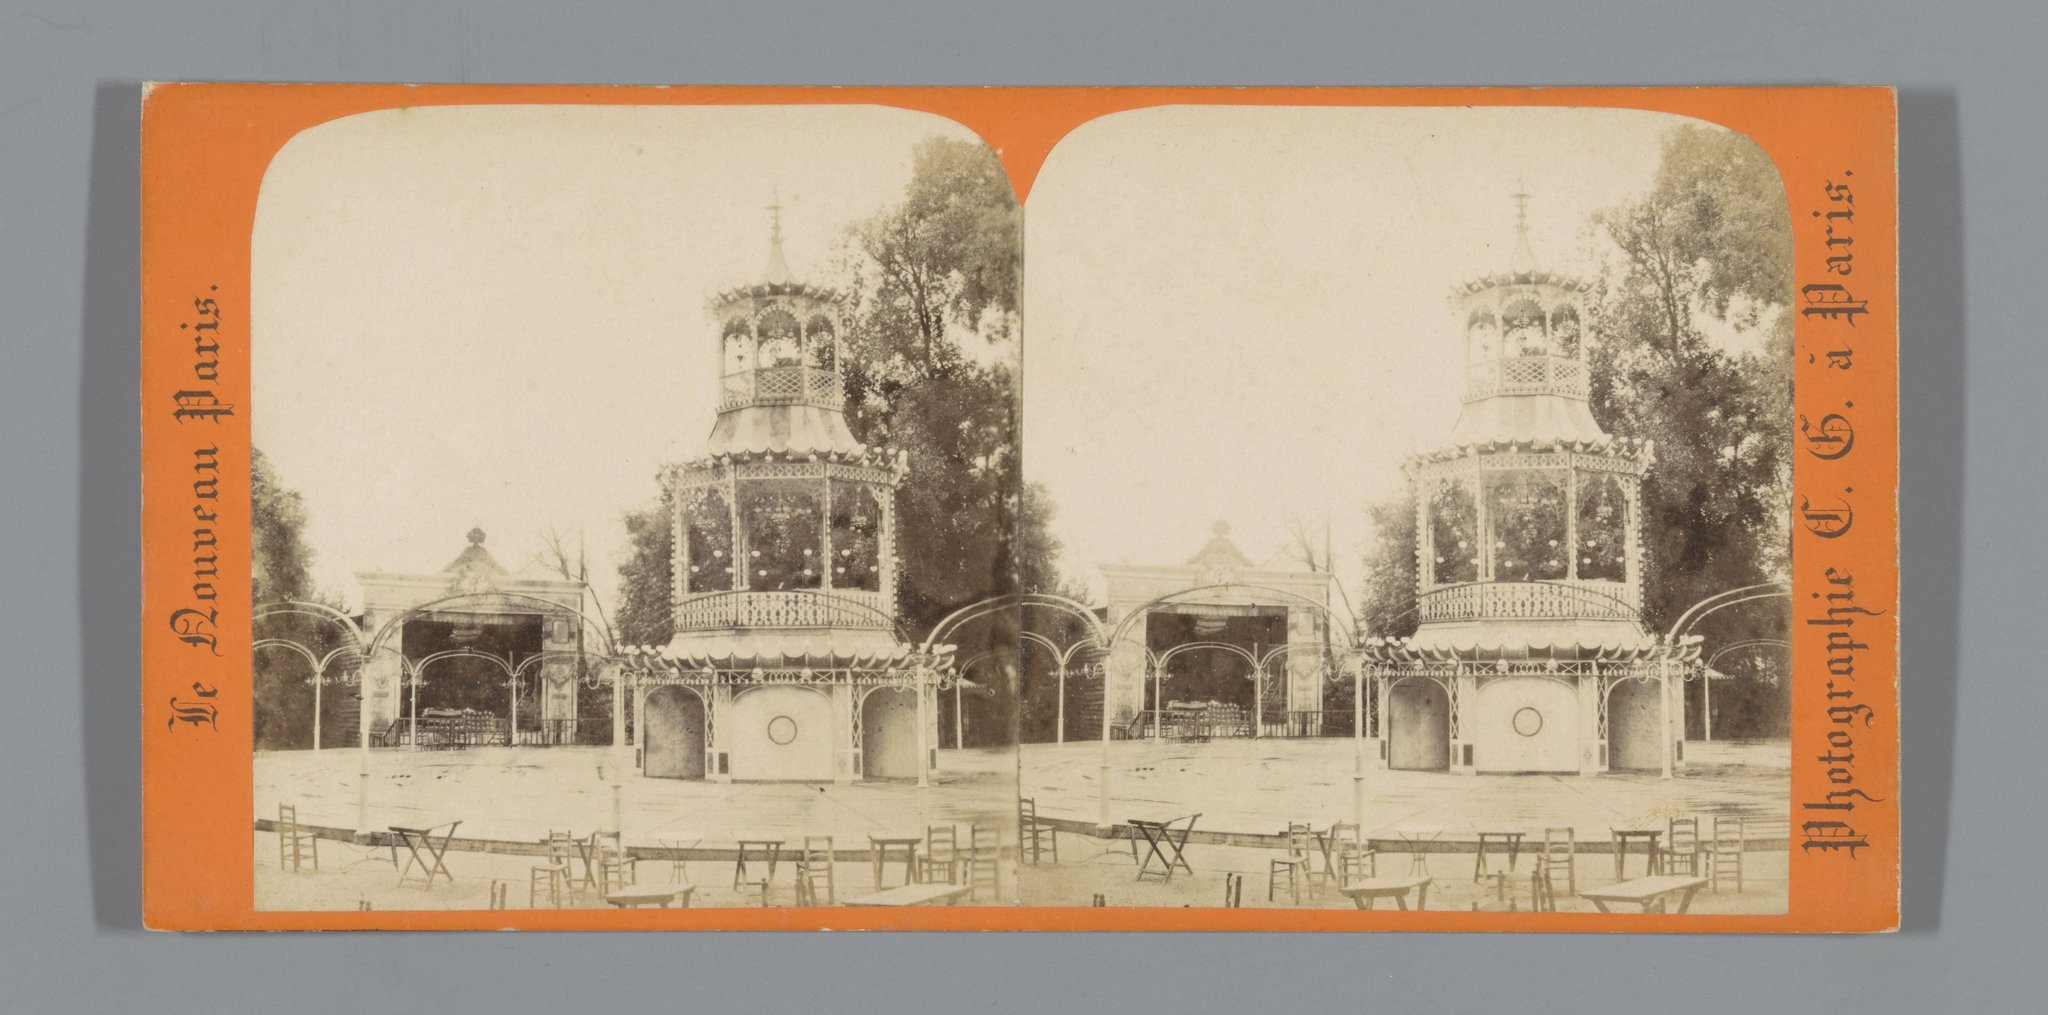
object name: stereograph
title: Prieel en een podium (vermoedelijk) in de tuin van het Château d'Asnières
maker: charles gérard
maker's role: fotograaf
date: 1850-1875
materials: cardboard, photographic support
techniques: albumen print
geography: ile-de-france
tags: set, scenery ~ stage, garden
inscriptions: inscription: ‘Asnières’